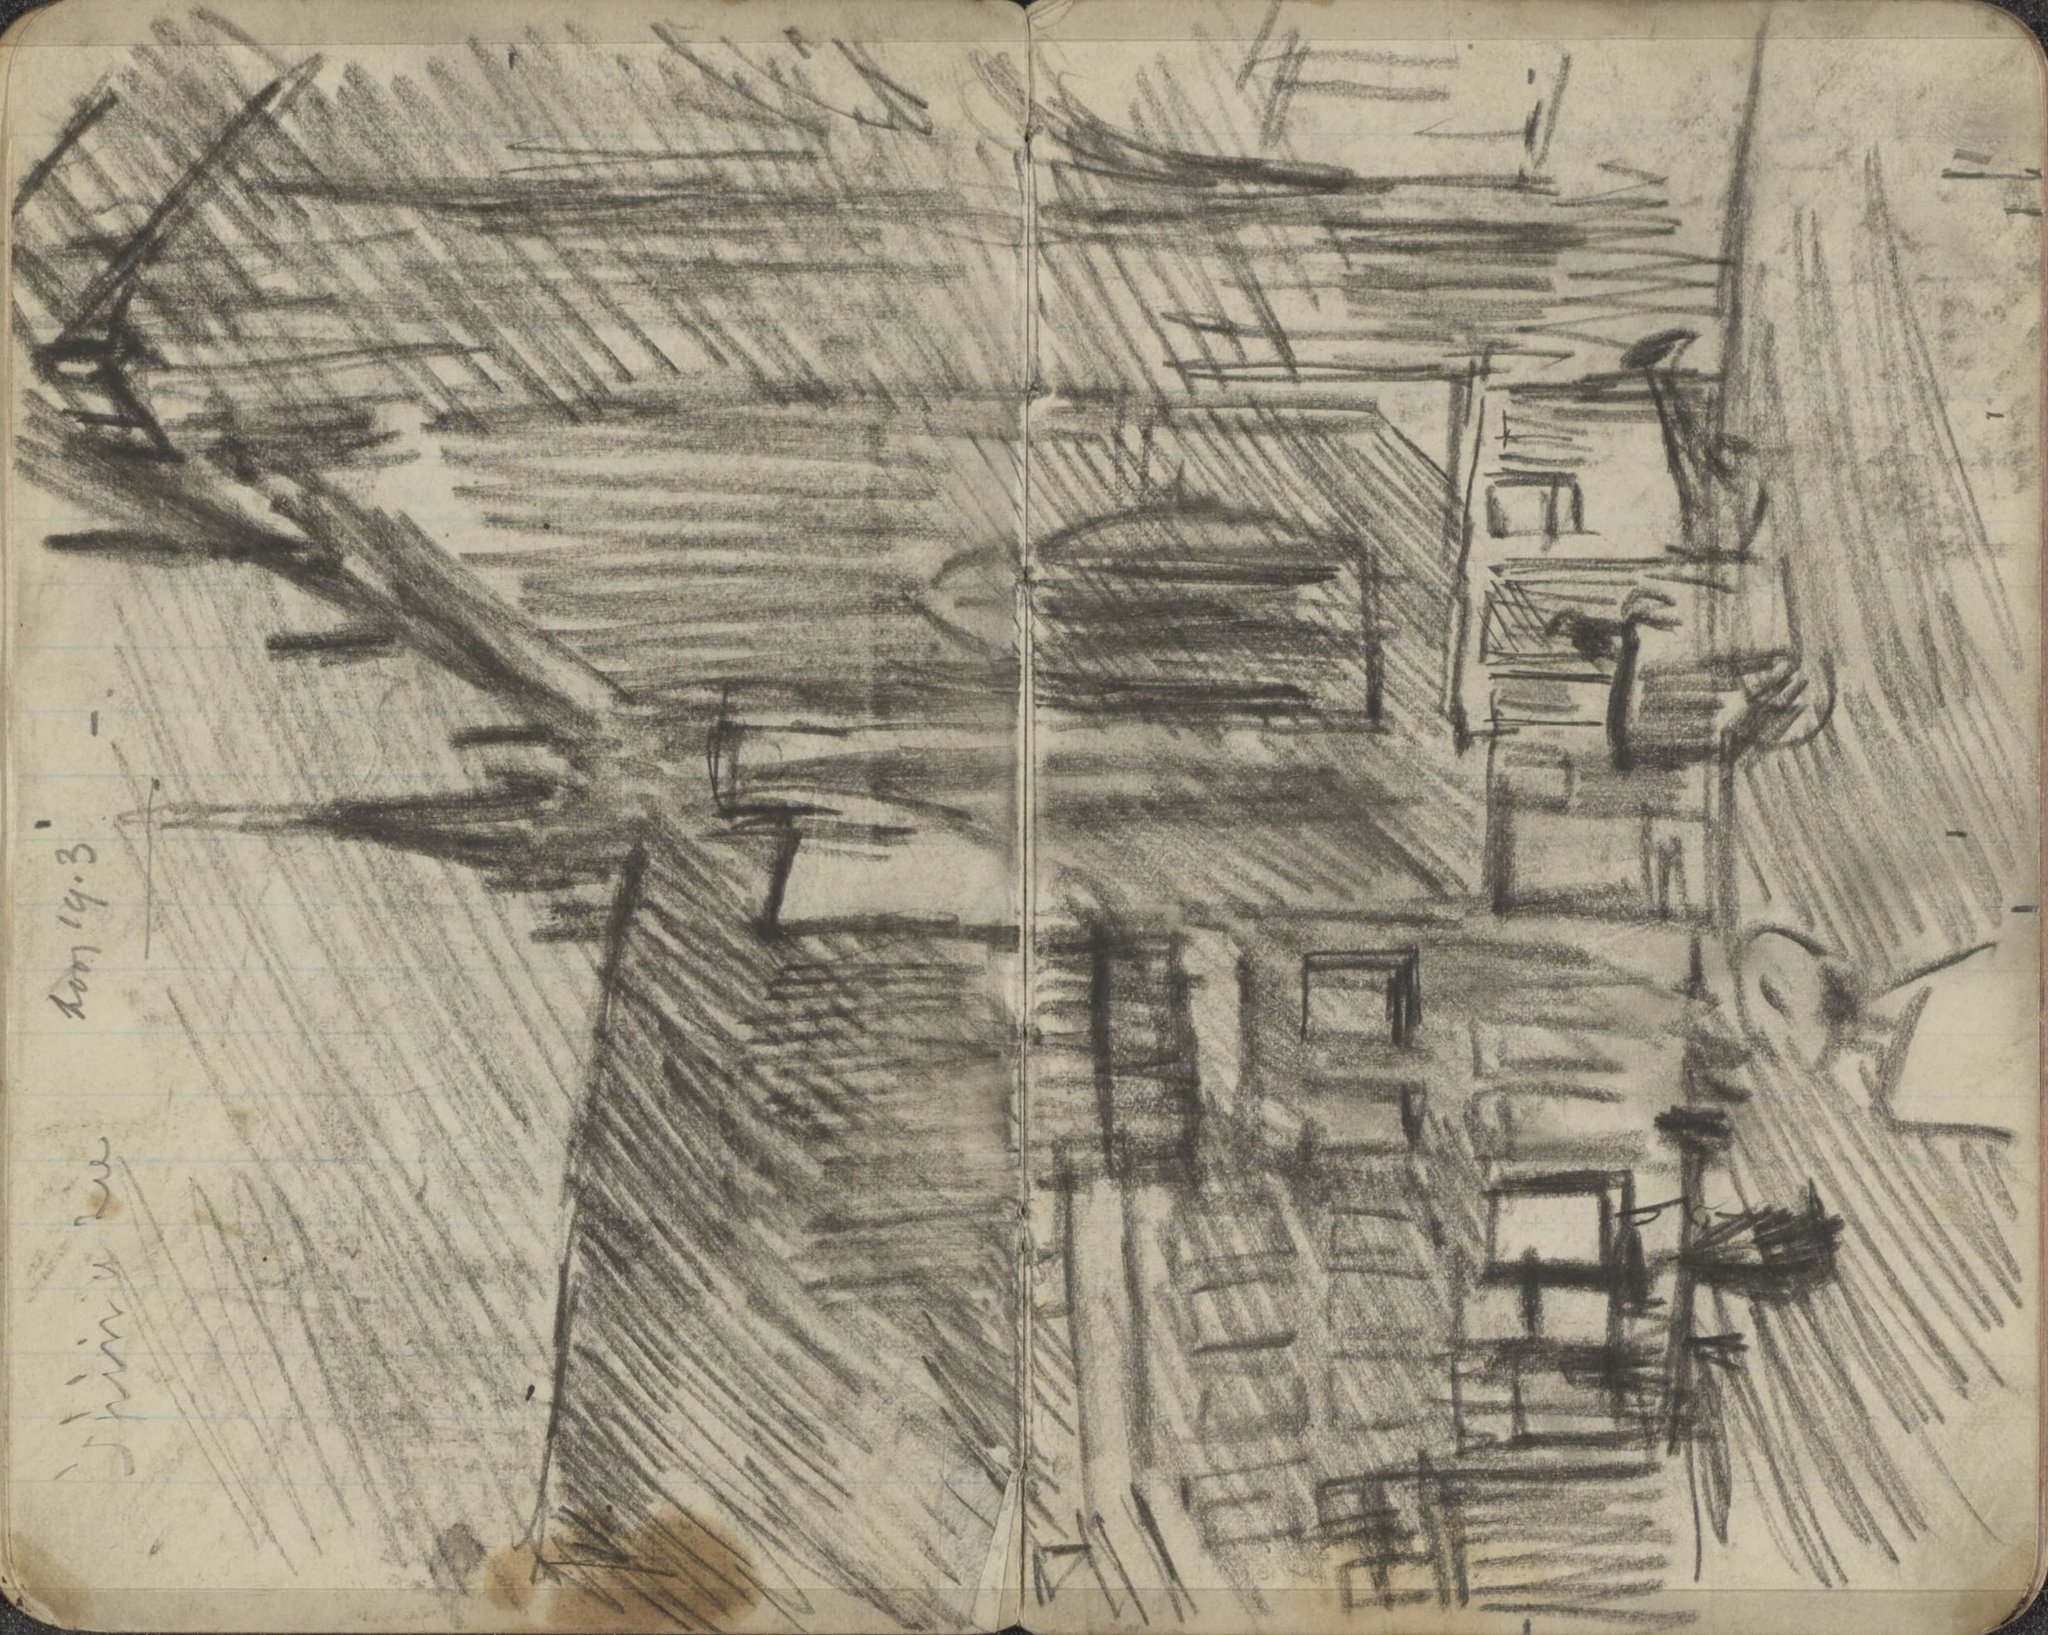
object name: sketchbook leaf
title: Nieuwe Kerk te Amsterdam, gezien vanaf de Nieuwezijds Voorburgwal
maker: george hendrik breitner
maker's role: draughtsman, painter, print maker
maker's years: 1857-1923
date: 1894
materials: chalk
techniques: stumping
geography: amsterdam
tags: church (exterior), civic architecture; edifices; dwellings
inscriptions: annotation: ‘spinazie/ hoog 19.3’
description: Pagina 7 en pagina 8 uit een schetsboek met 31 bladen.